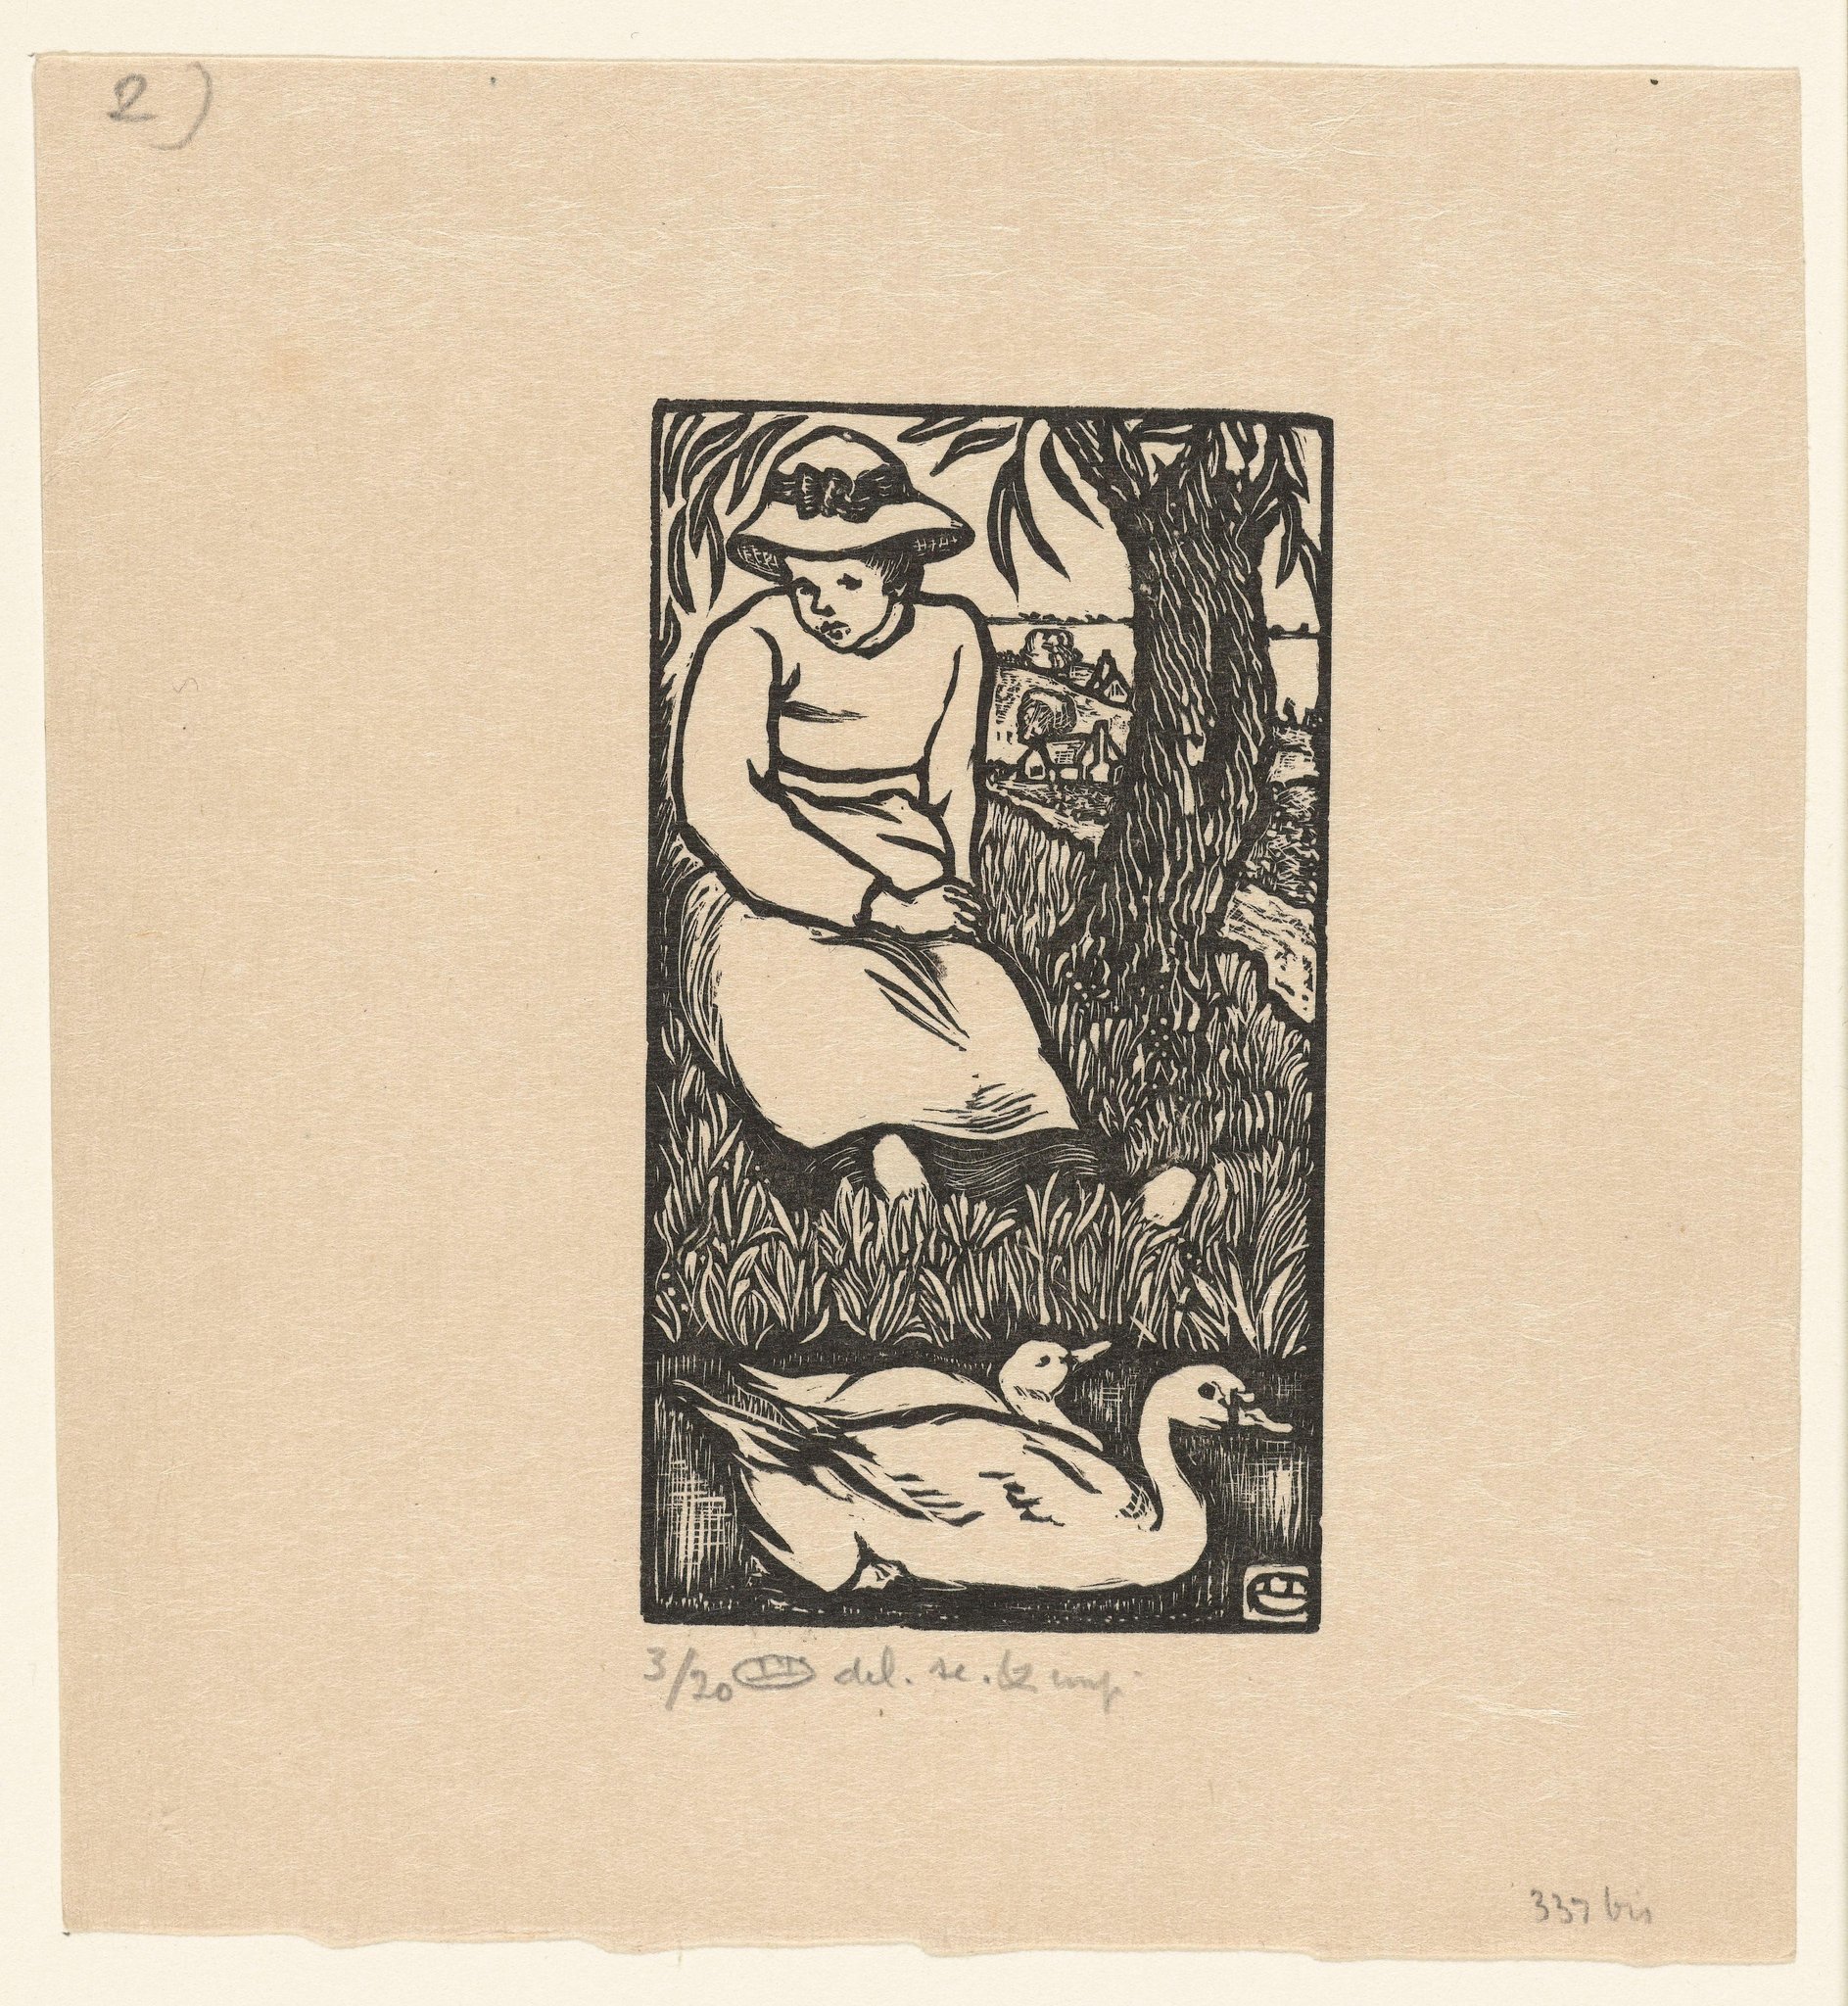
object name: print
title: La Fille au Canards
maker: lucien pissarro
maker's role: painter, print maker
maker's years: 1863-1944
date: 1912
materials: paper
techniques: engraving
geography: england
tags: adolescent, young woman, maiden, ducks (domestic waterbirds)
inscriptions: collector's mark: Lugt 2228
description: Een meisje zittend op het gras aan de waterkant, in het water twee eenden.